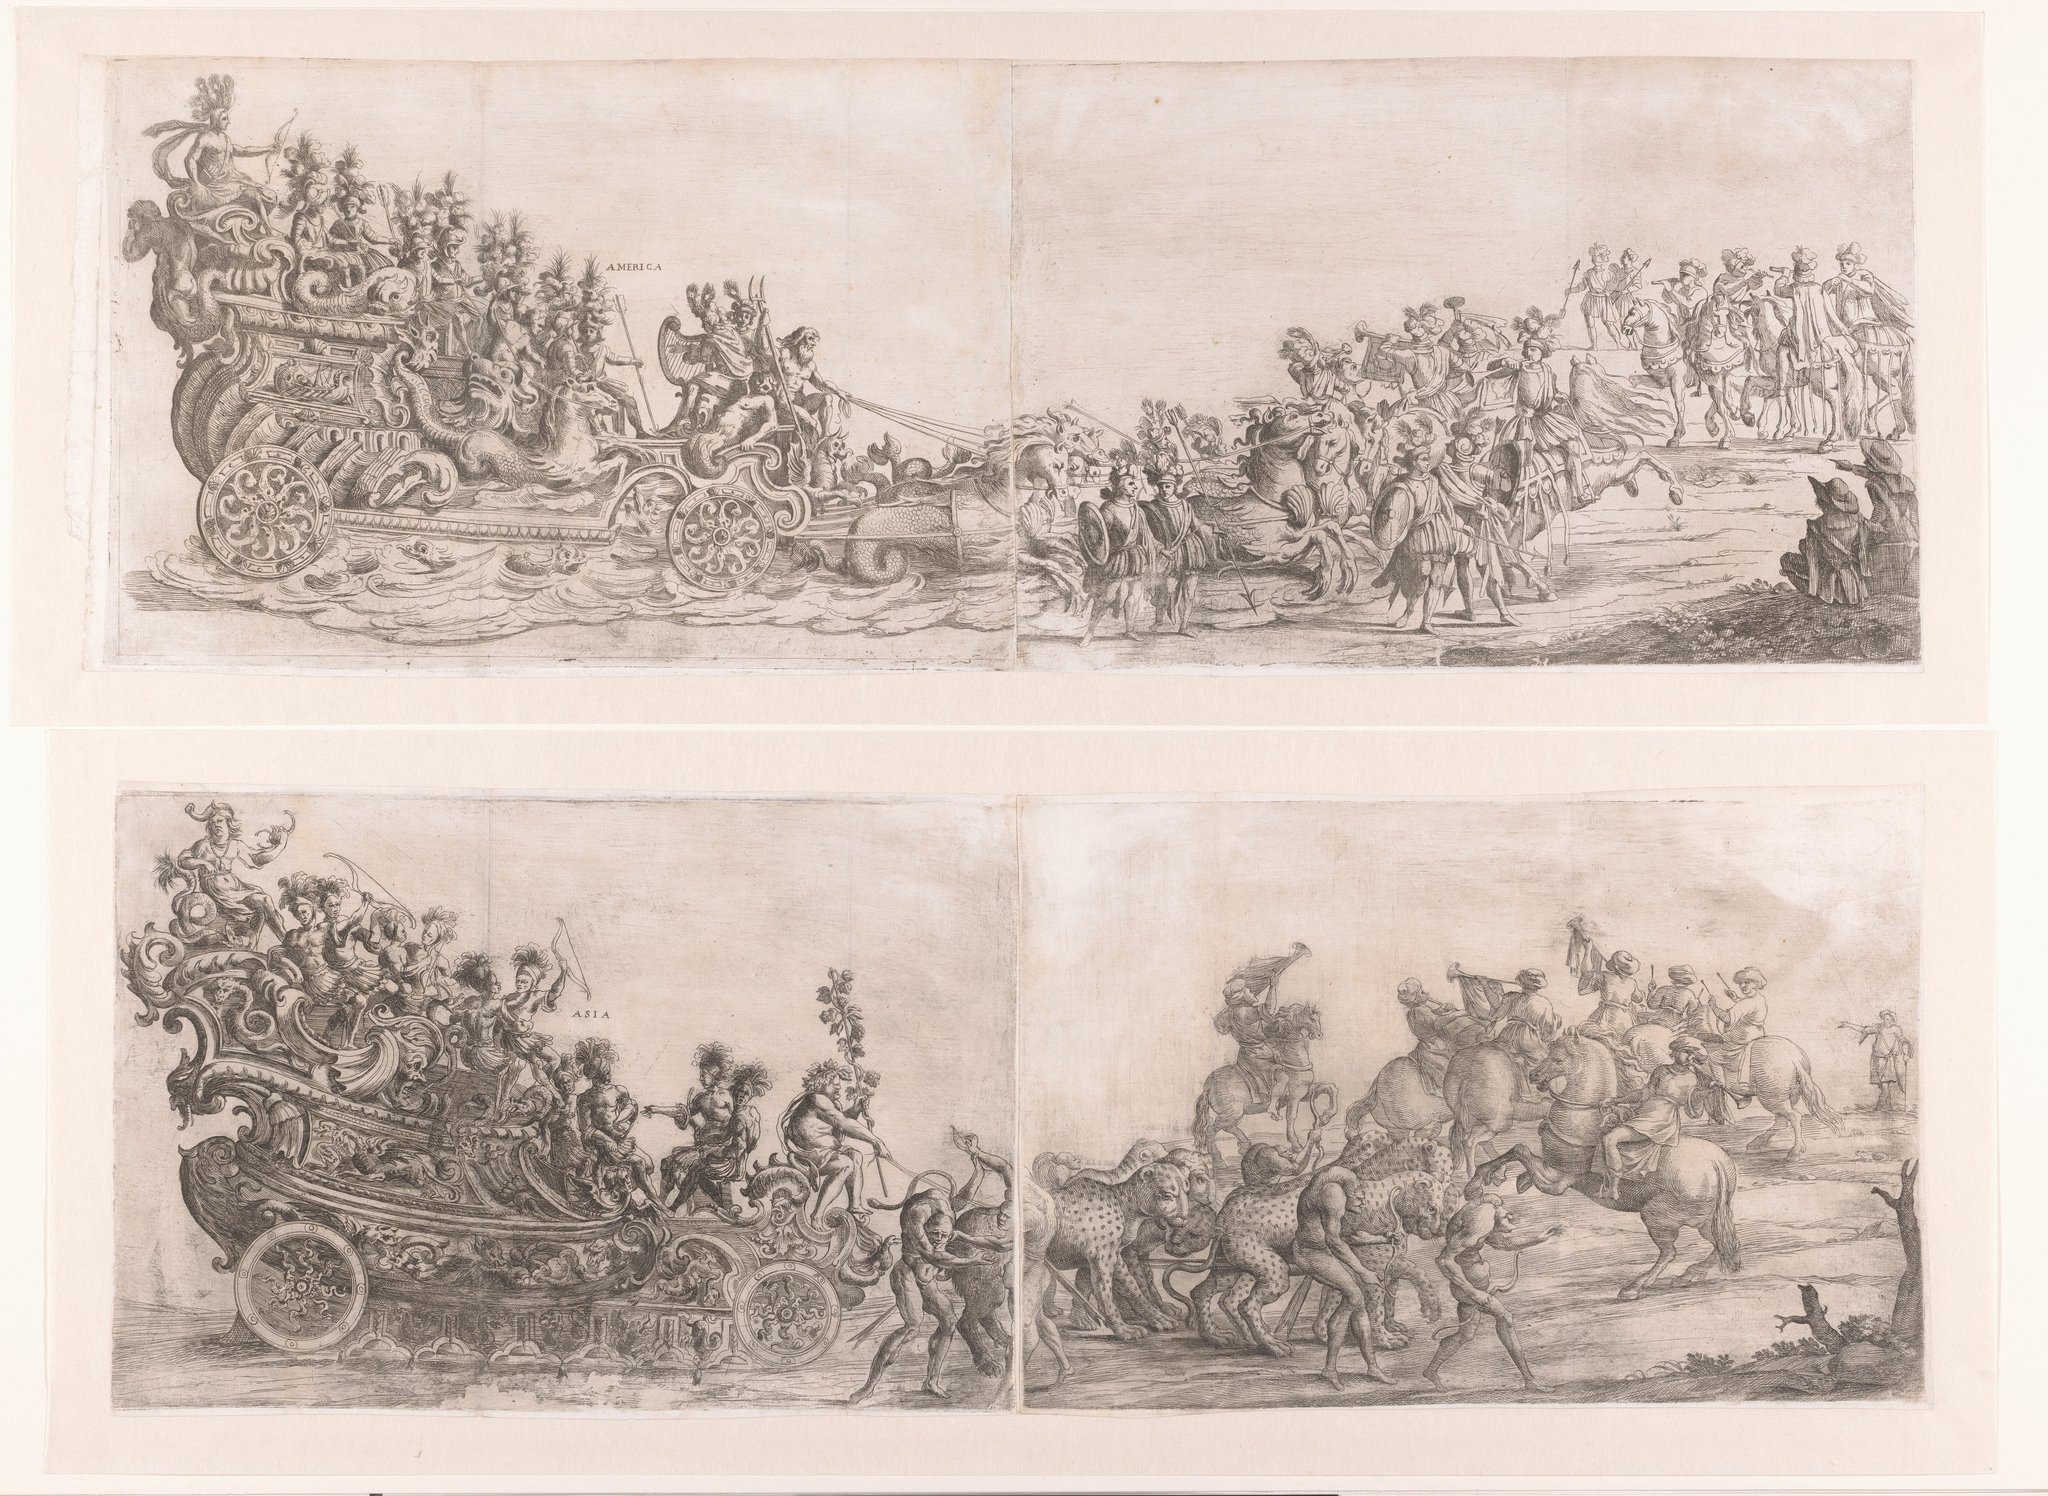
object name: print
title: Asia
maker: Anonymous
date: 1549-1699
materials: paper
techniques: etching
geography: italy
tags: (story of) bacchus (dionysus), liber, asia represented allegorically; 'asia' (ripa), chariot, triumphal car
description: Een triomfwagen met bovenop een figuur zittend op een slang, getrokken door panters gemend door Bacchus, en begeleid door figuren zonder hoofd met hun gezicht op hun borst.